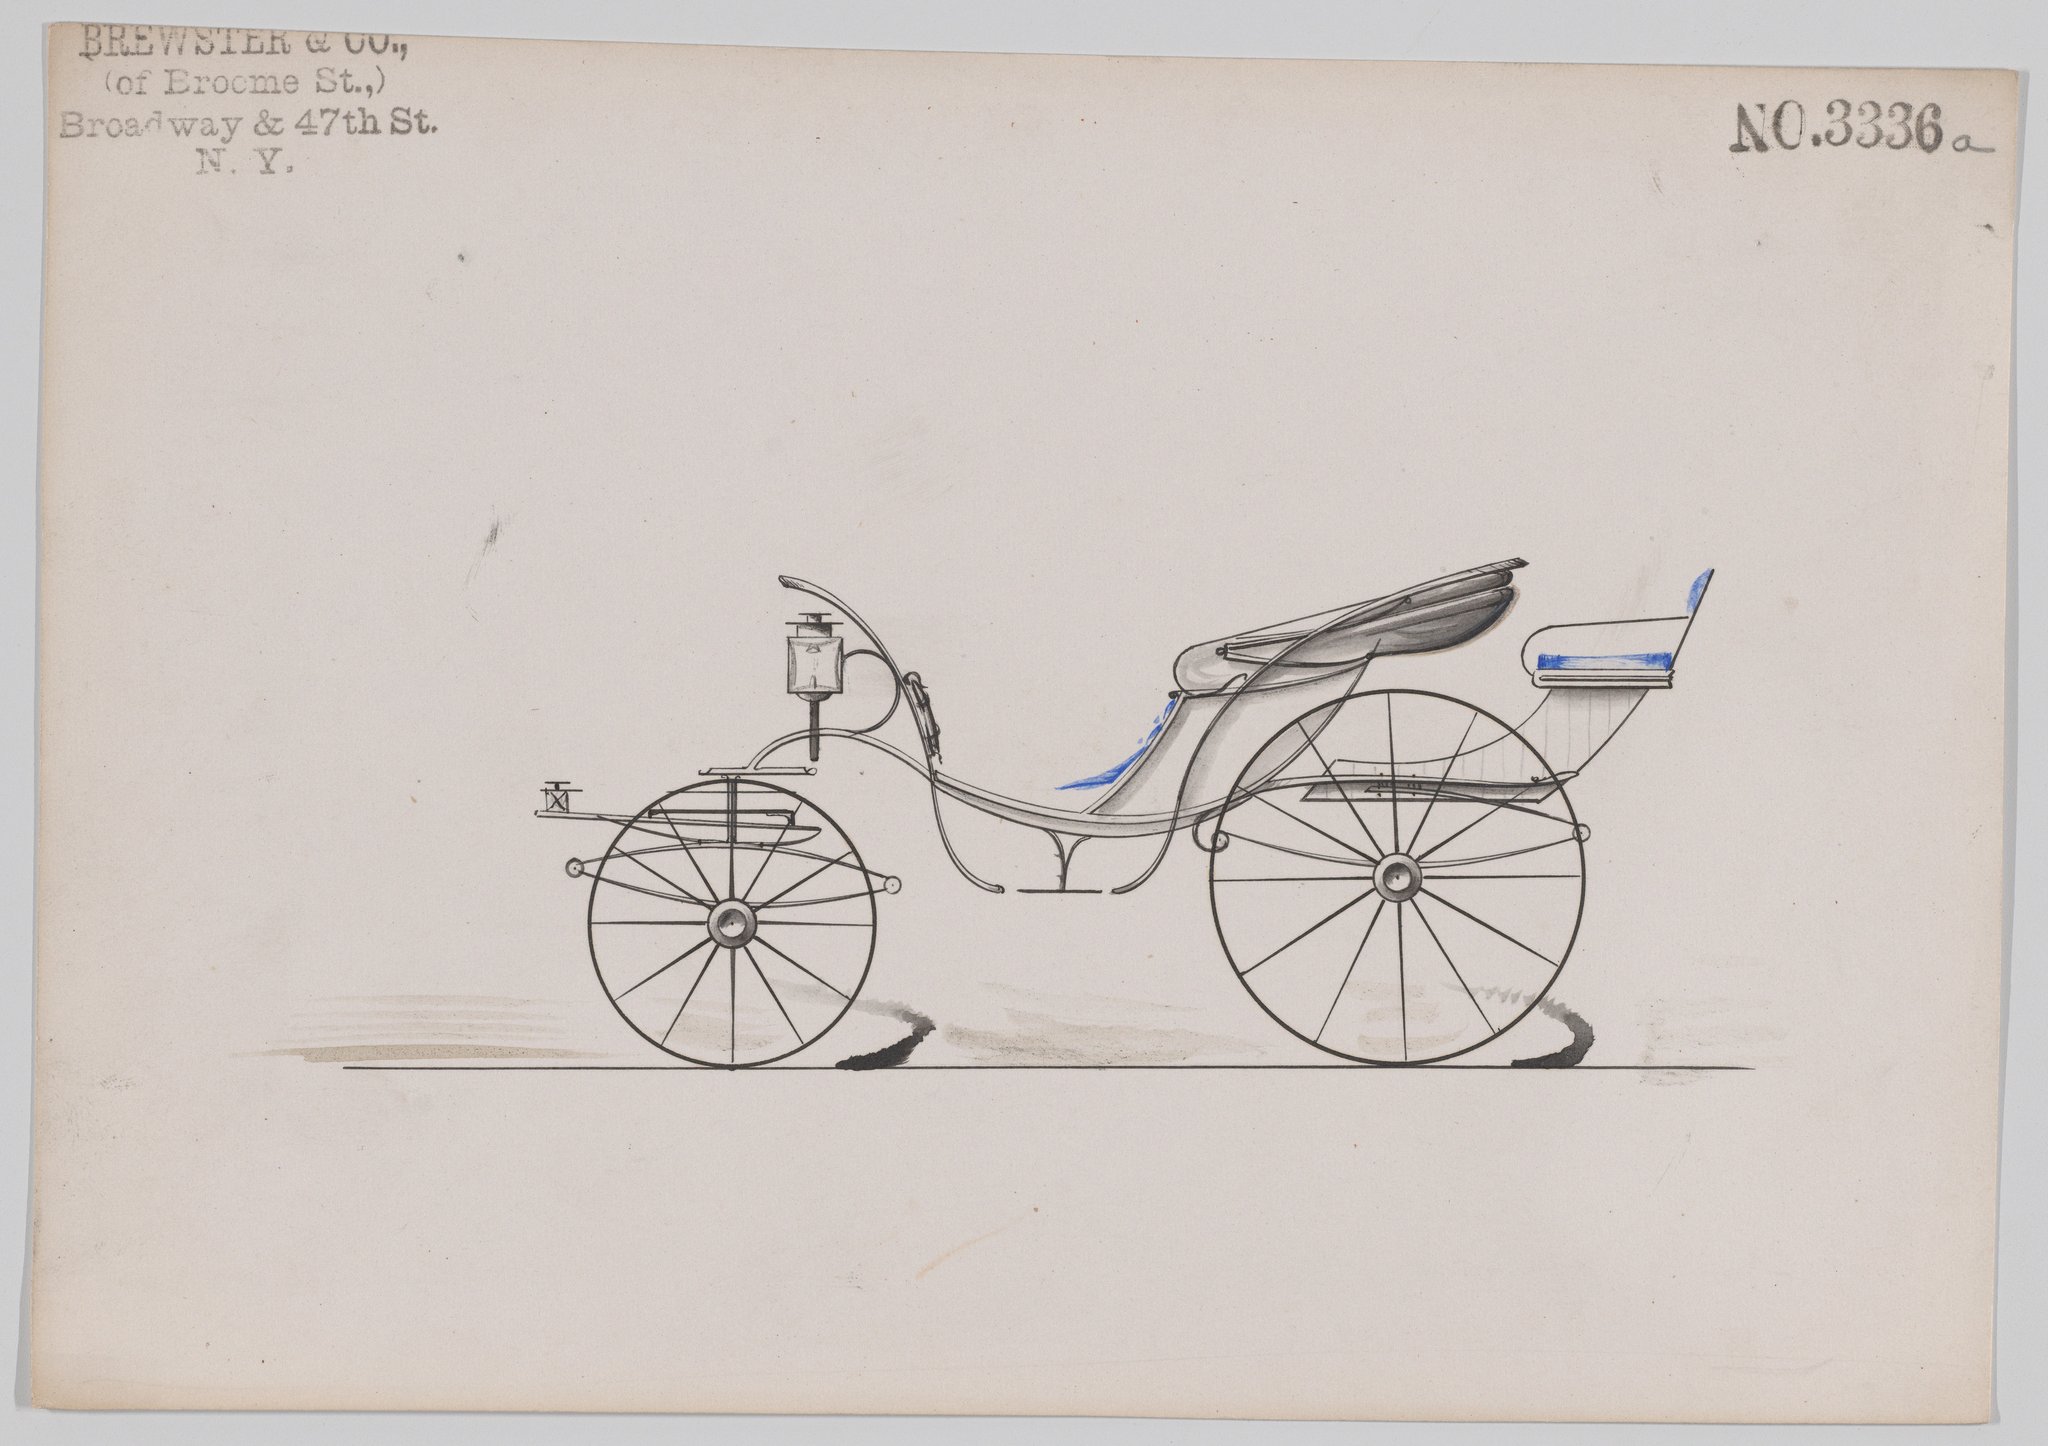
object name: drawing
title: Design for Pony Phaeton, no. 3336a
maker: brewster & co.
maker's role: manufacturer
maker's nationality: american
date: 1877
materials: gouache, ink, watercolor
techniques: pen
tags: carriages